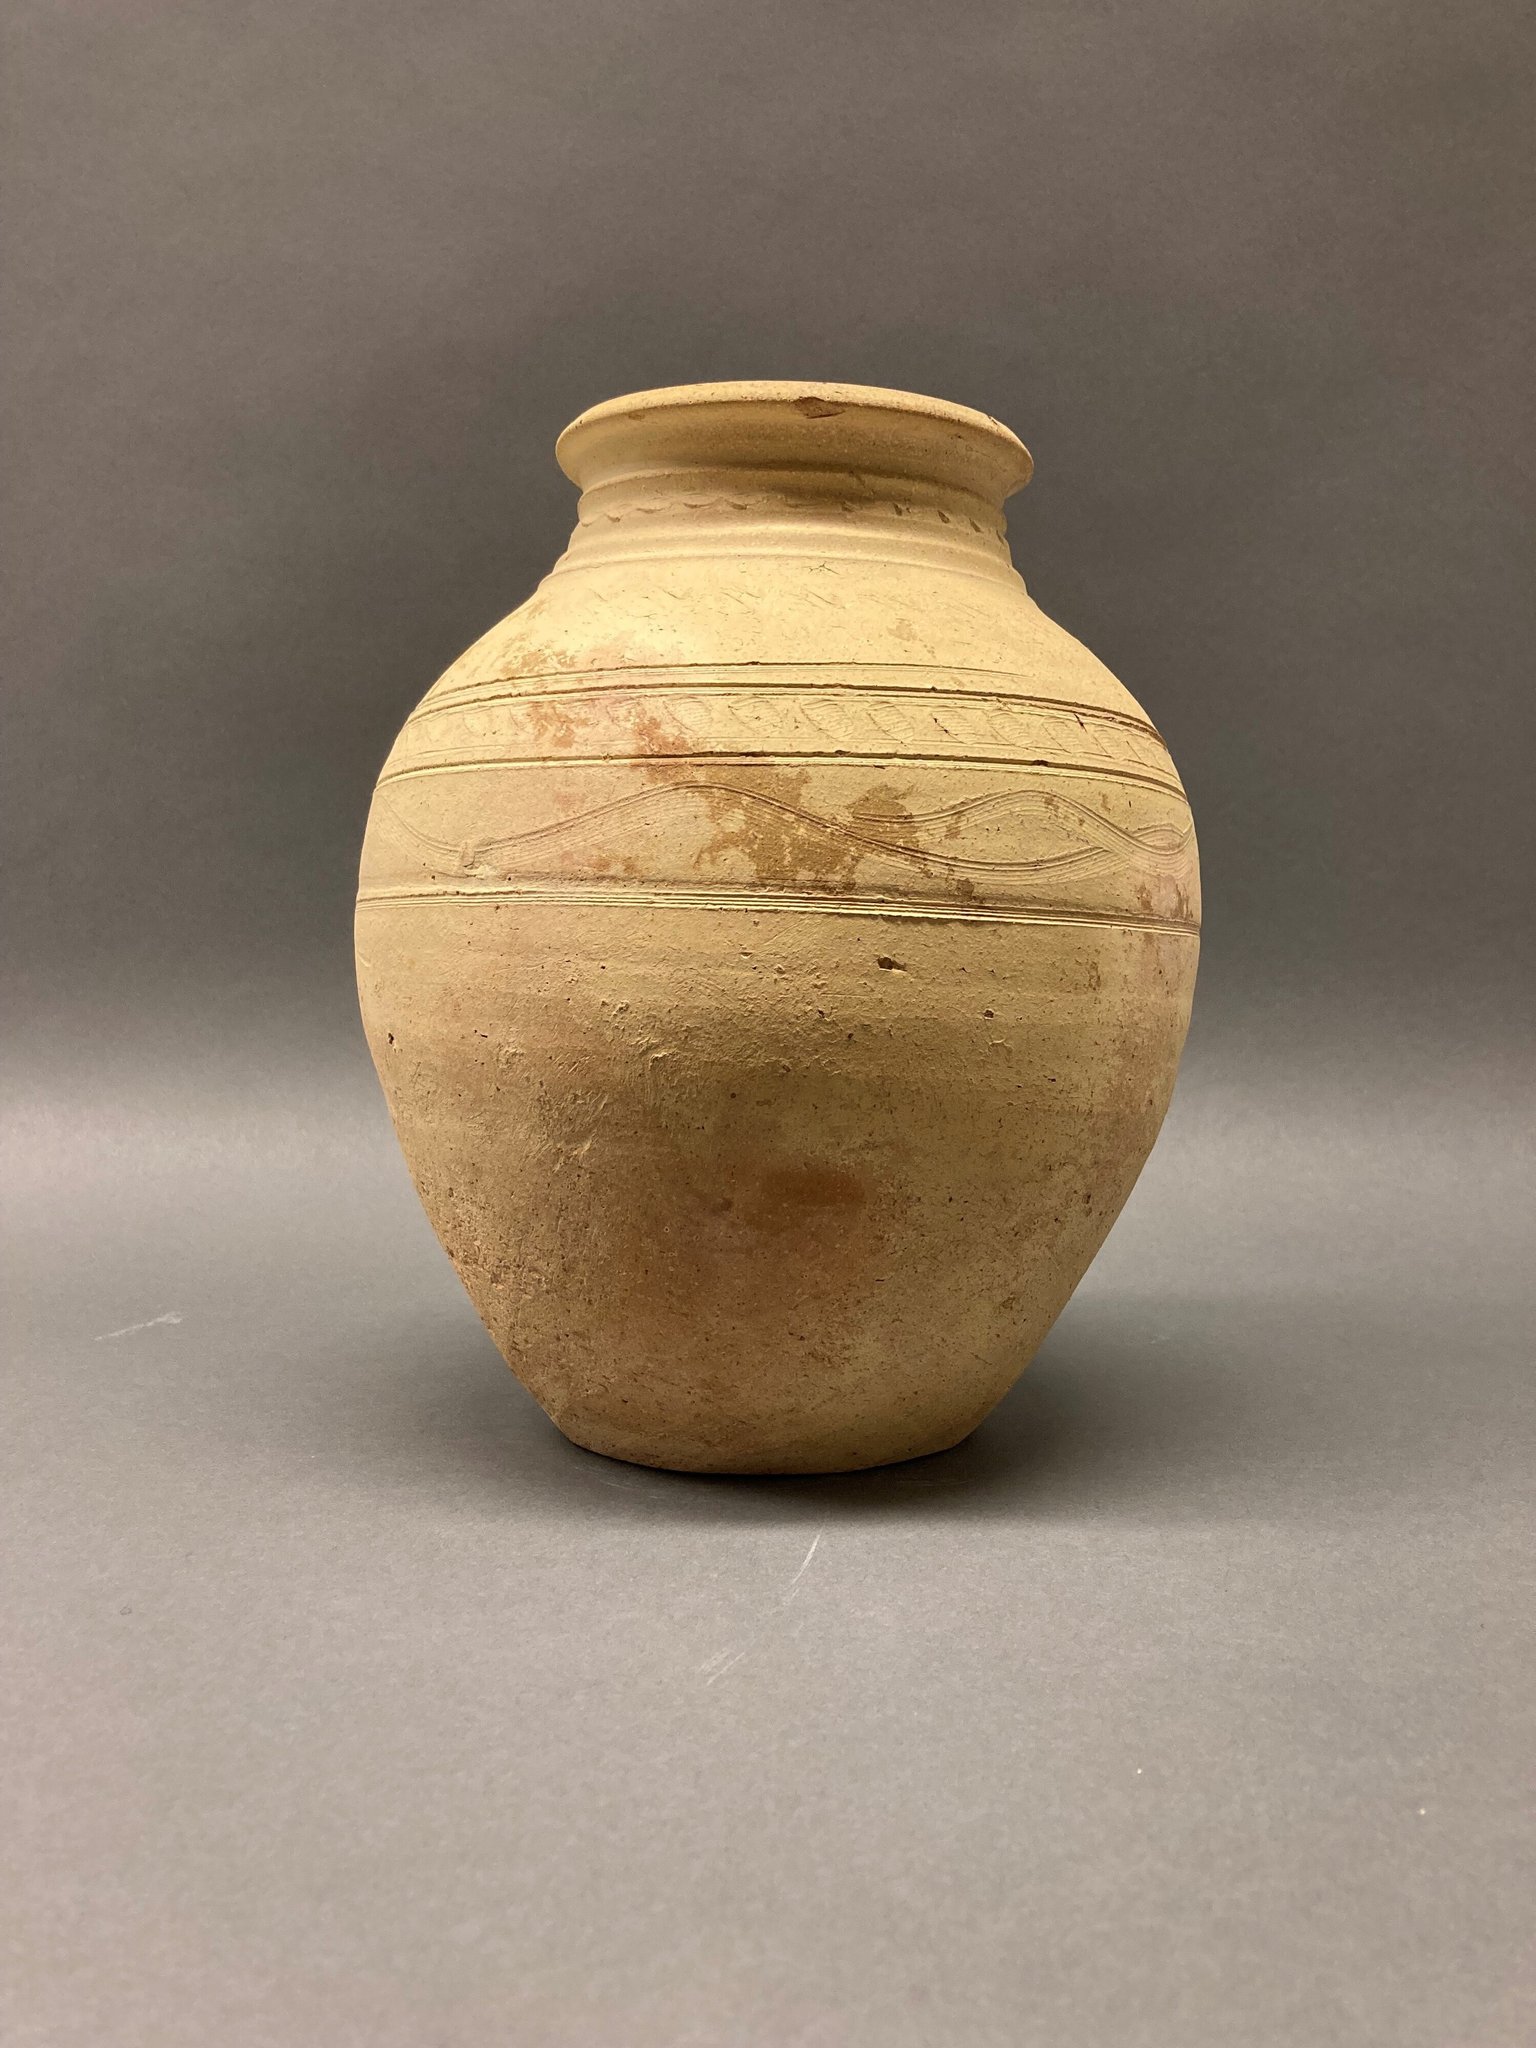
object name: jar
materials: earthenware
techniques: incising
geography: iran